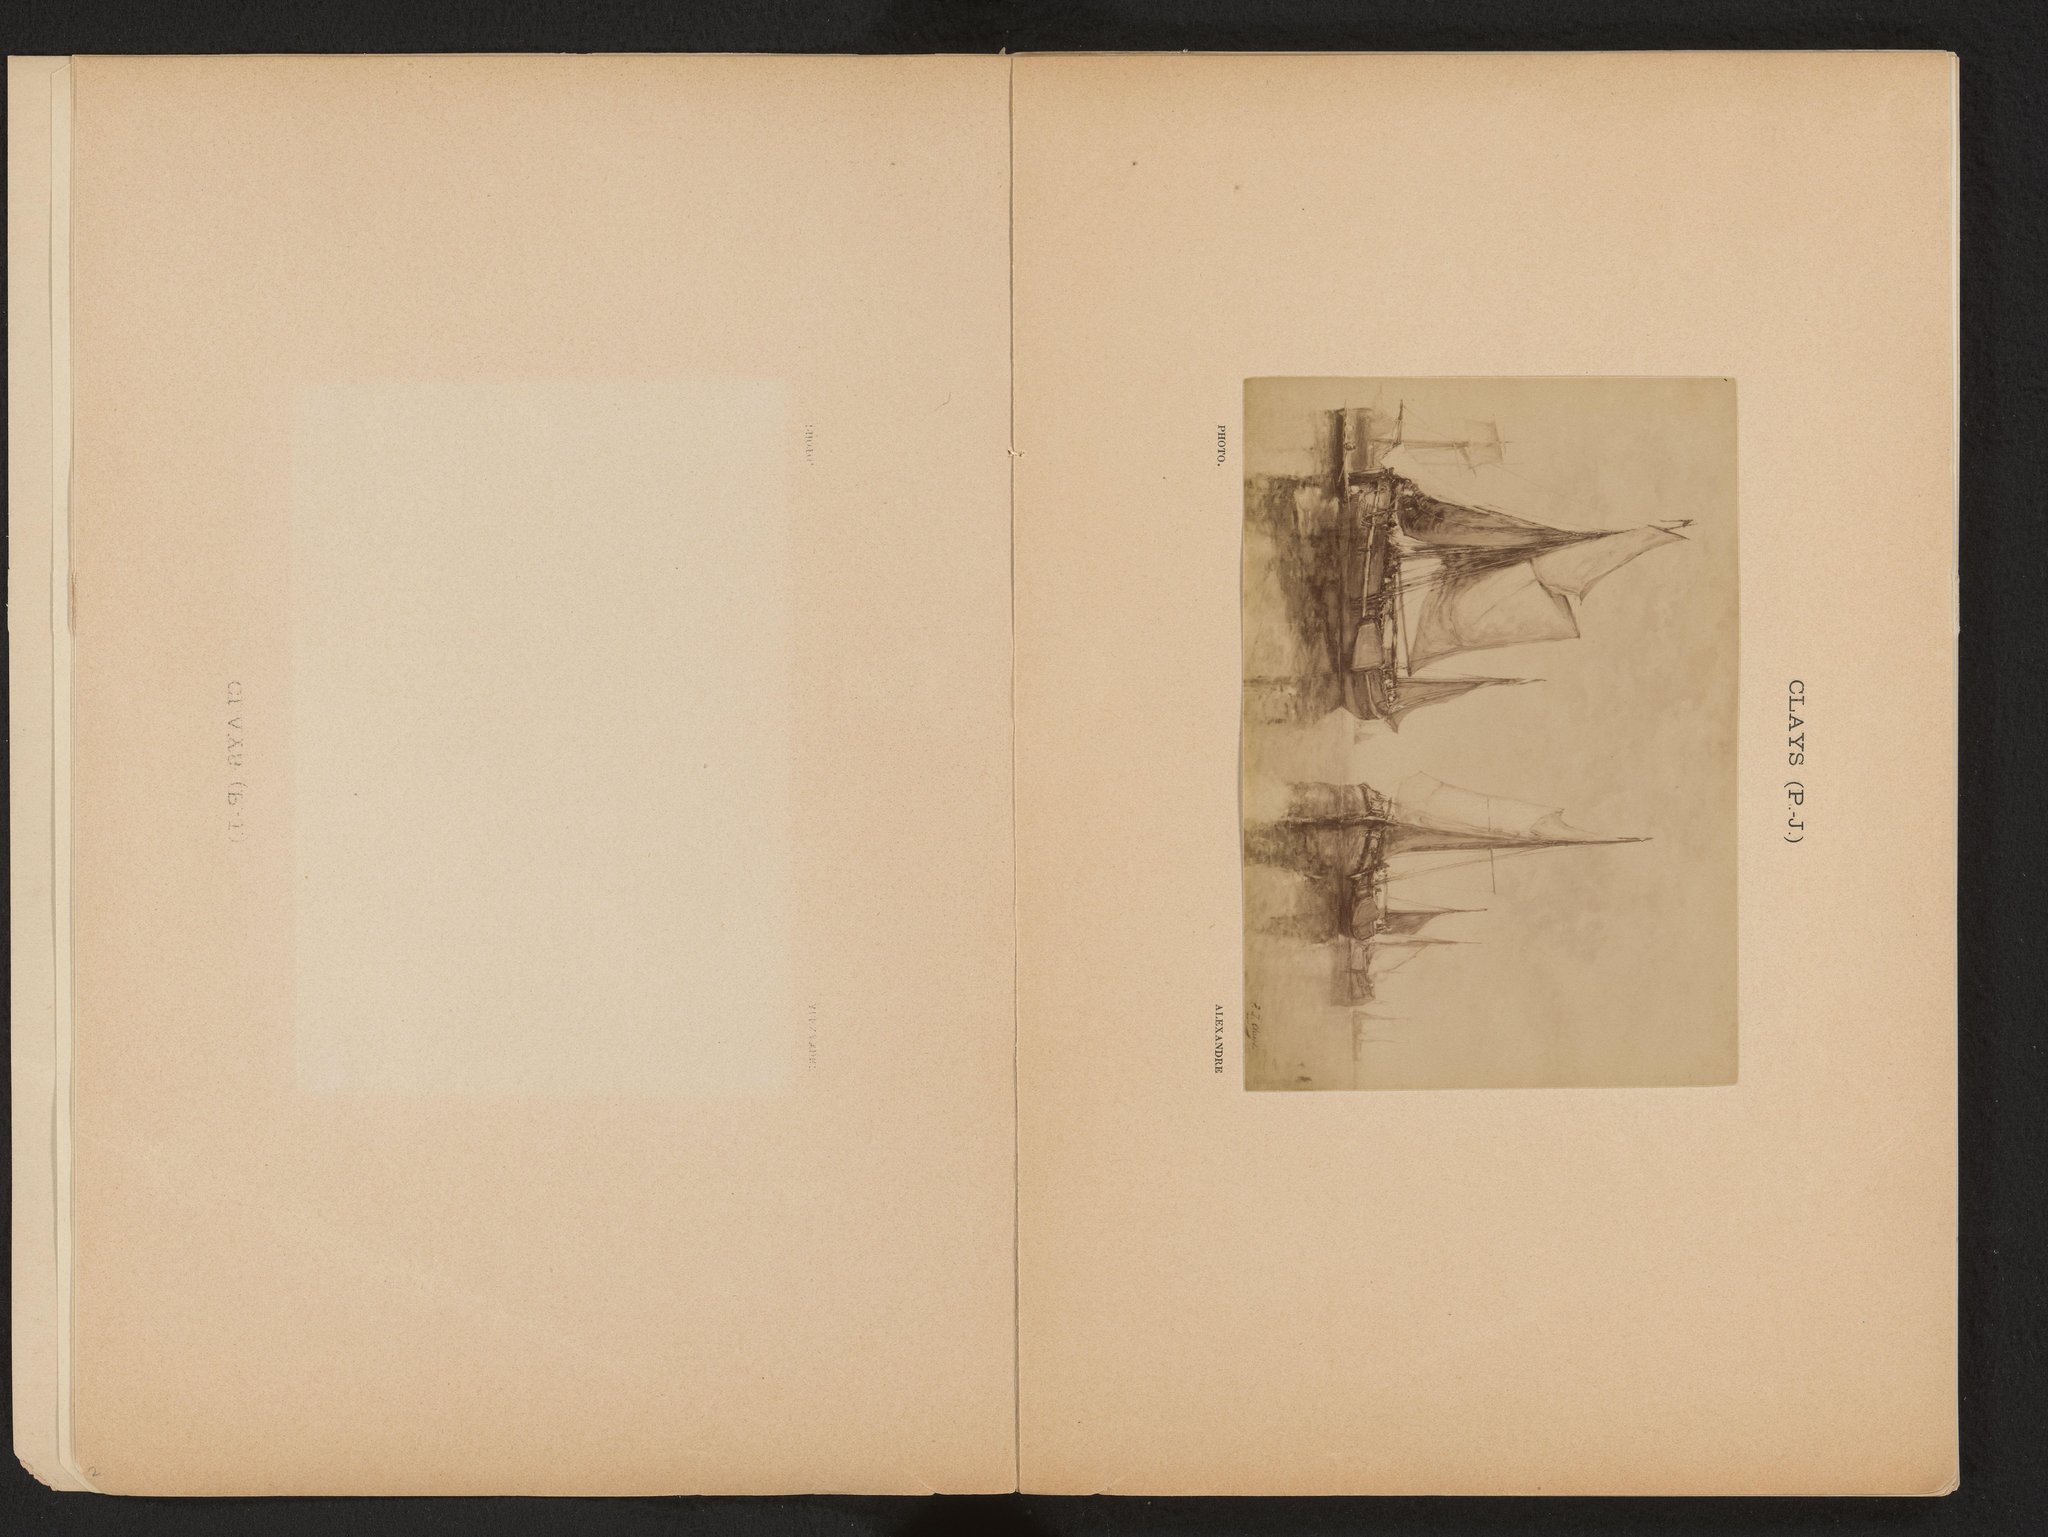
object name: photograph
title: Clays (P.-J.)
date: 1888-1893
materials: photographic support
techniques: albumen print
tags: sailing-ship, sailing-boat, landscapes with waters, waterscapes, seascapes (in the temperate zone), painting, drawing and the graphic arts